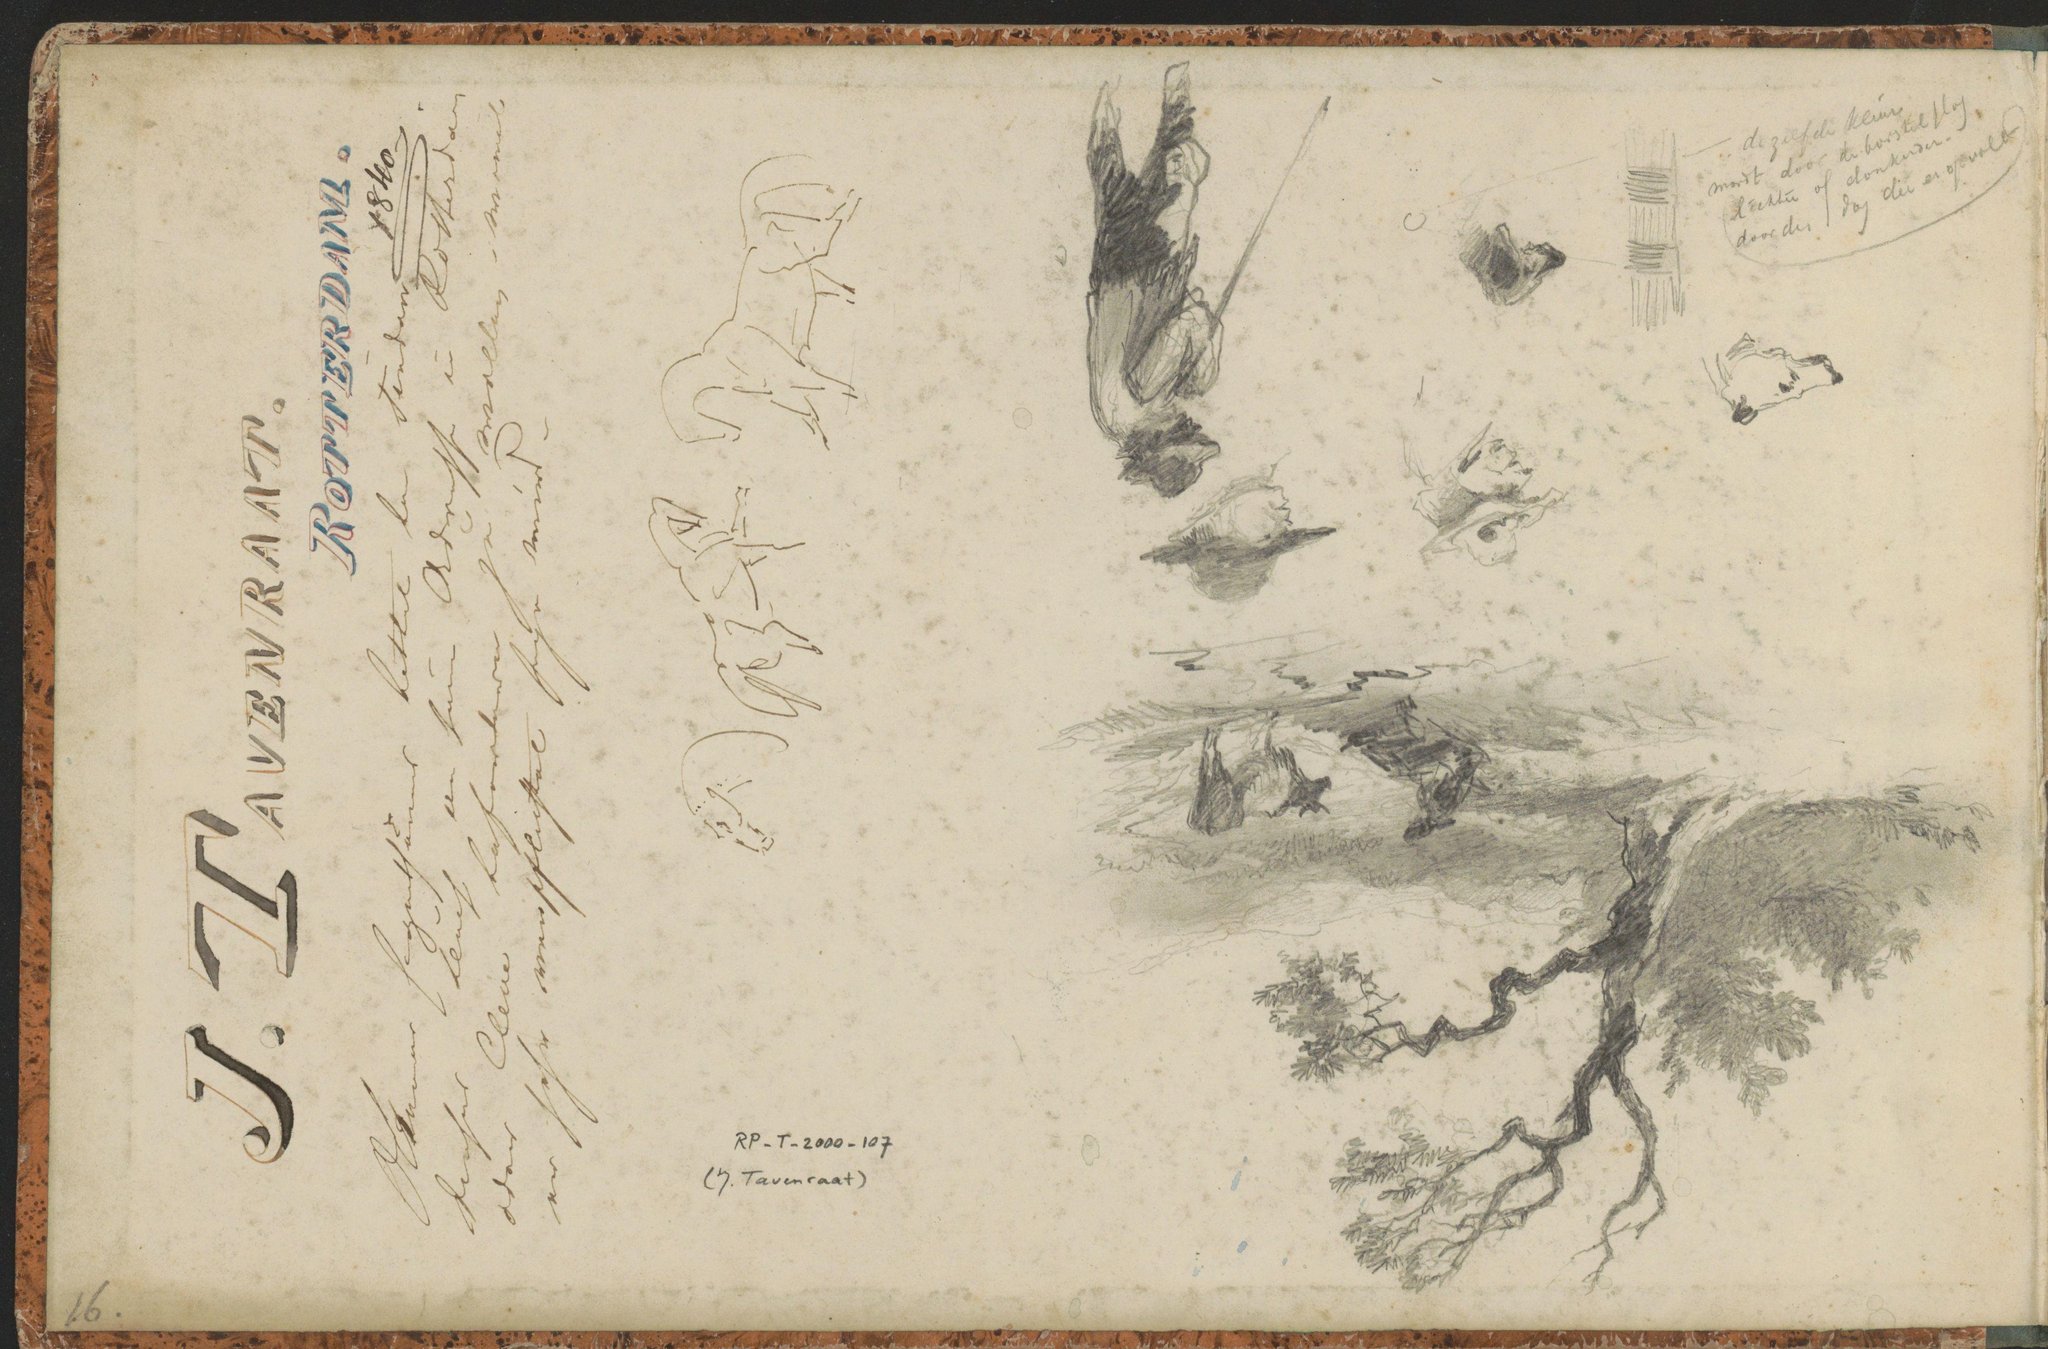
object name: endleaf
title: Paarden, hondenkoppen, een herder en een landschap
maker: johannes tavenraat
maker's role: draughtsman, painter, print maker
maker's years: 1809-1881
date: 1840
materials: ink, paper, pencil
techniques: pen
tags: herding, herdsman, herdswoman, shepherd, shepherdess, cowherd, etc., horse, landscapes (+ landscape with figures, staffage), dog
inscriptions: date and inscription: ‘J. Tavenraat/ Rotterdam./ 1840’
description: Voorste schutblad uit een schetsboek met 33 bladen.